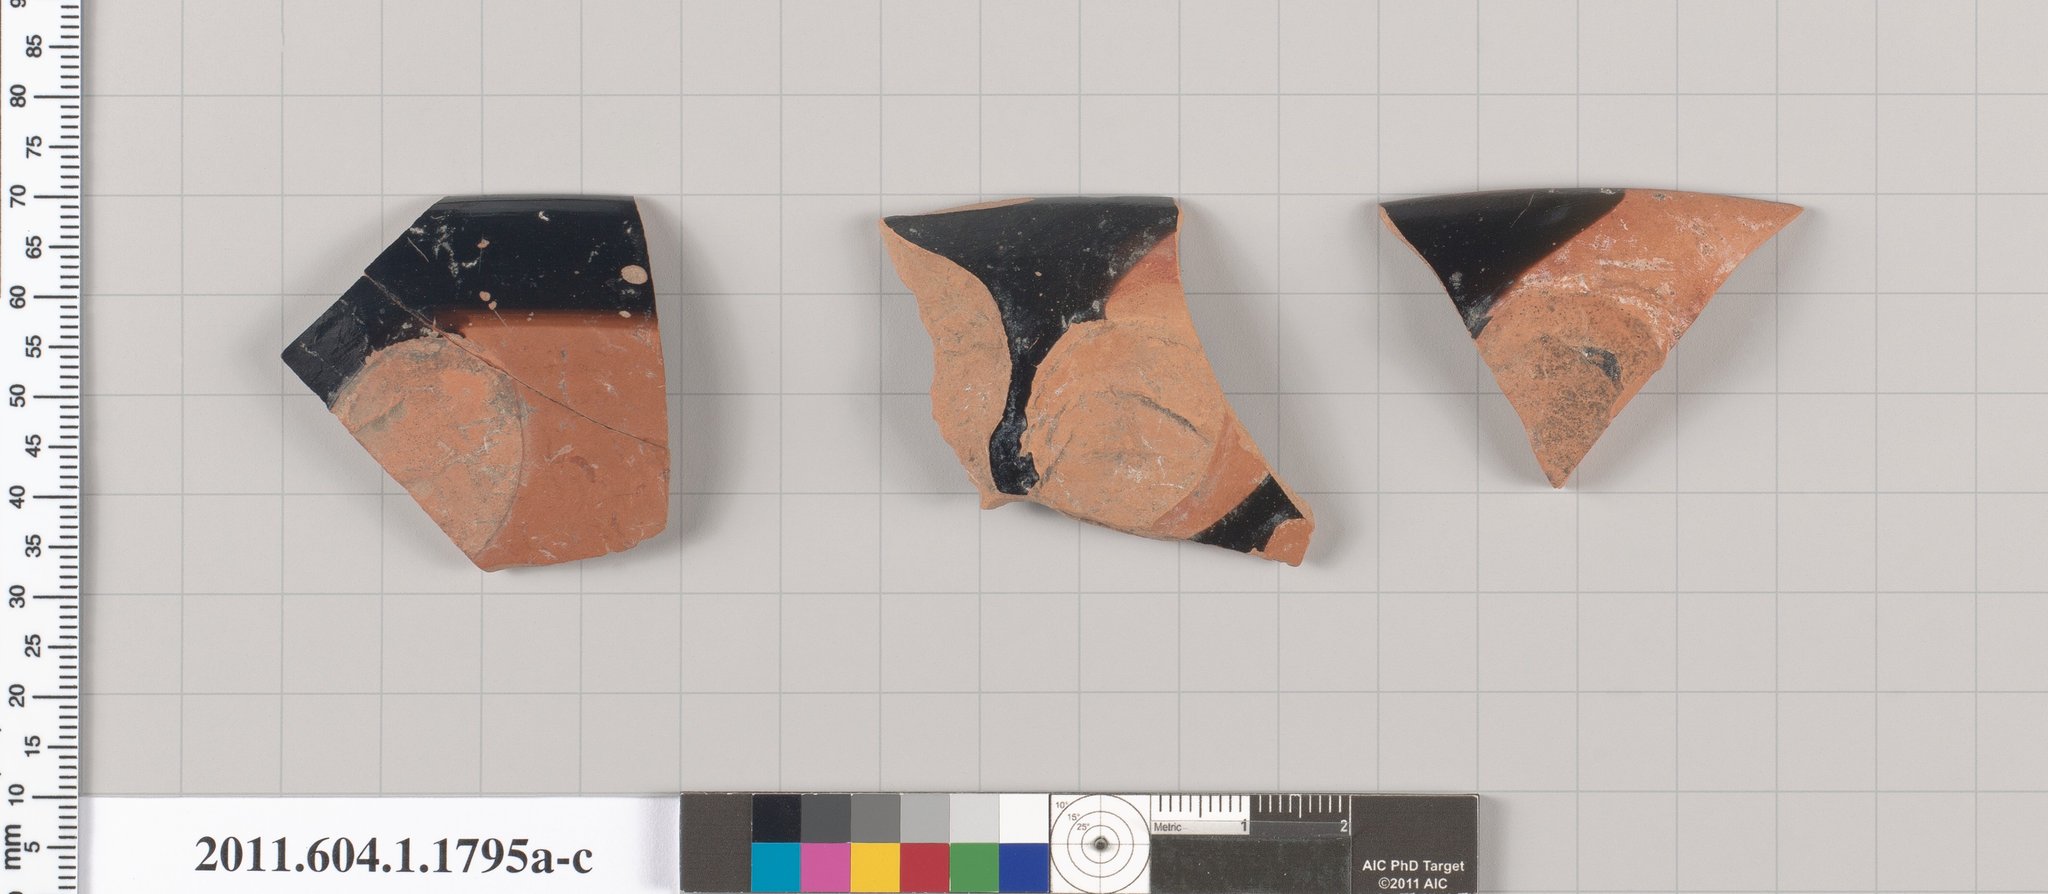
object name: kylix fragment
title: Terracotta rim fragments of kylikes(drinking cups)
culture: greek, attic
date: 500-401 BCE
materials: terracotta